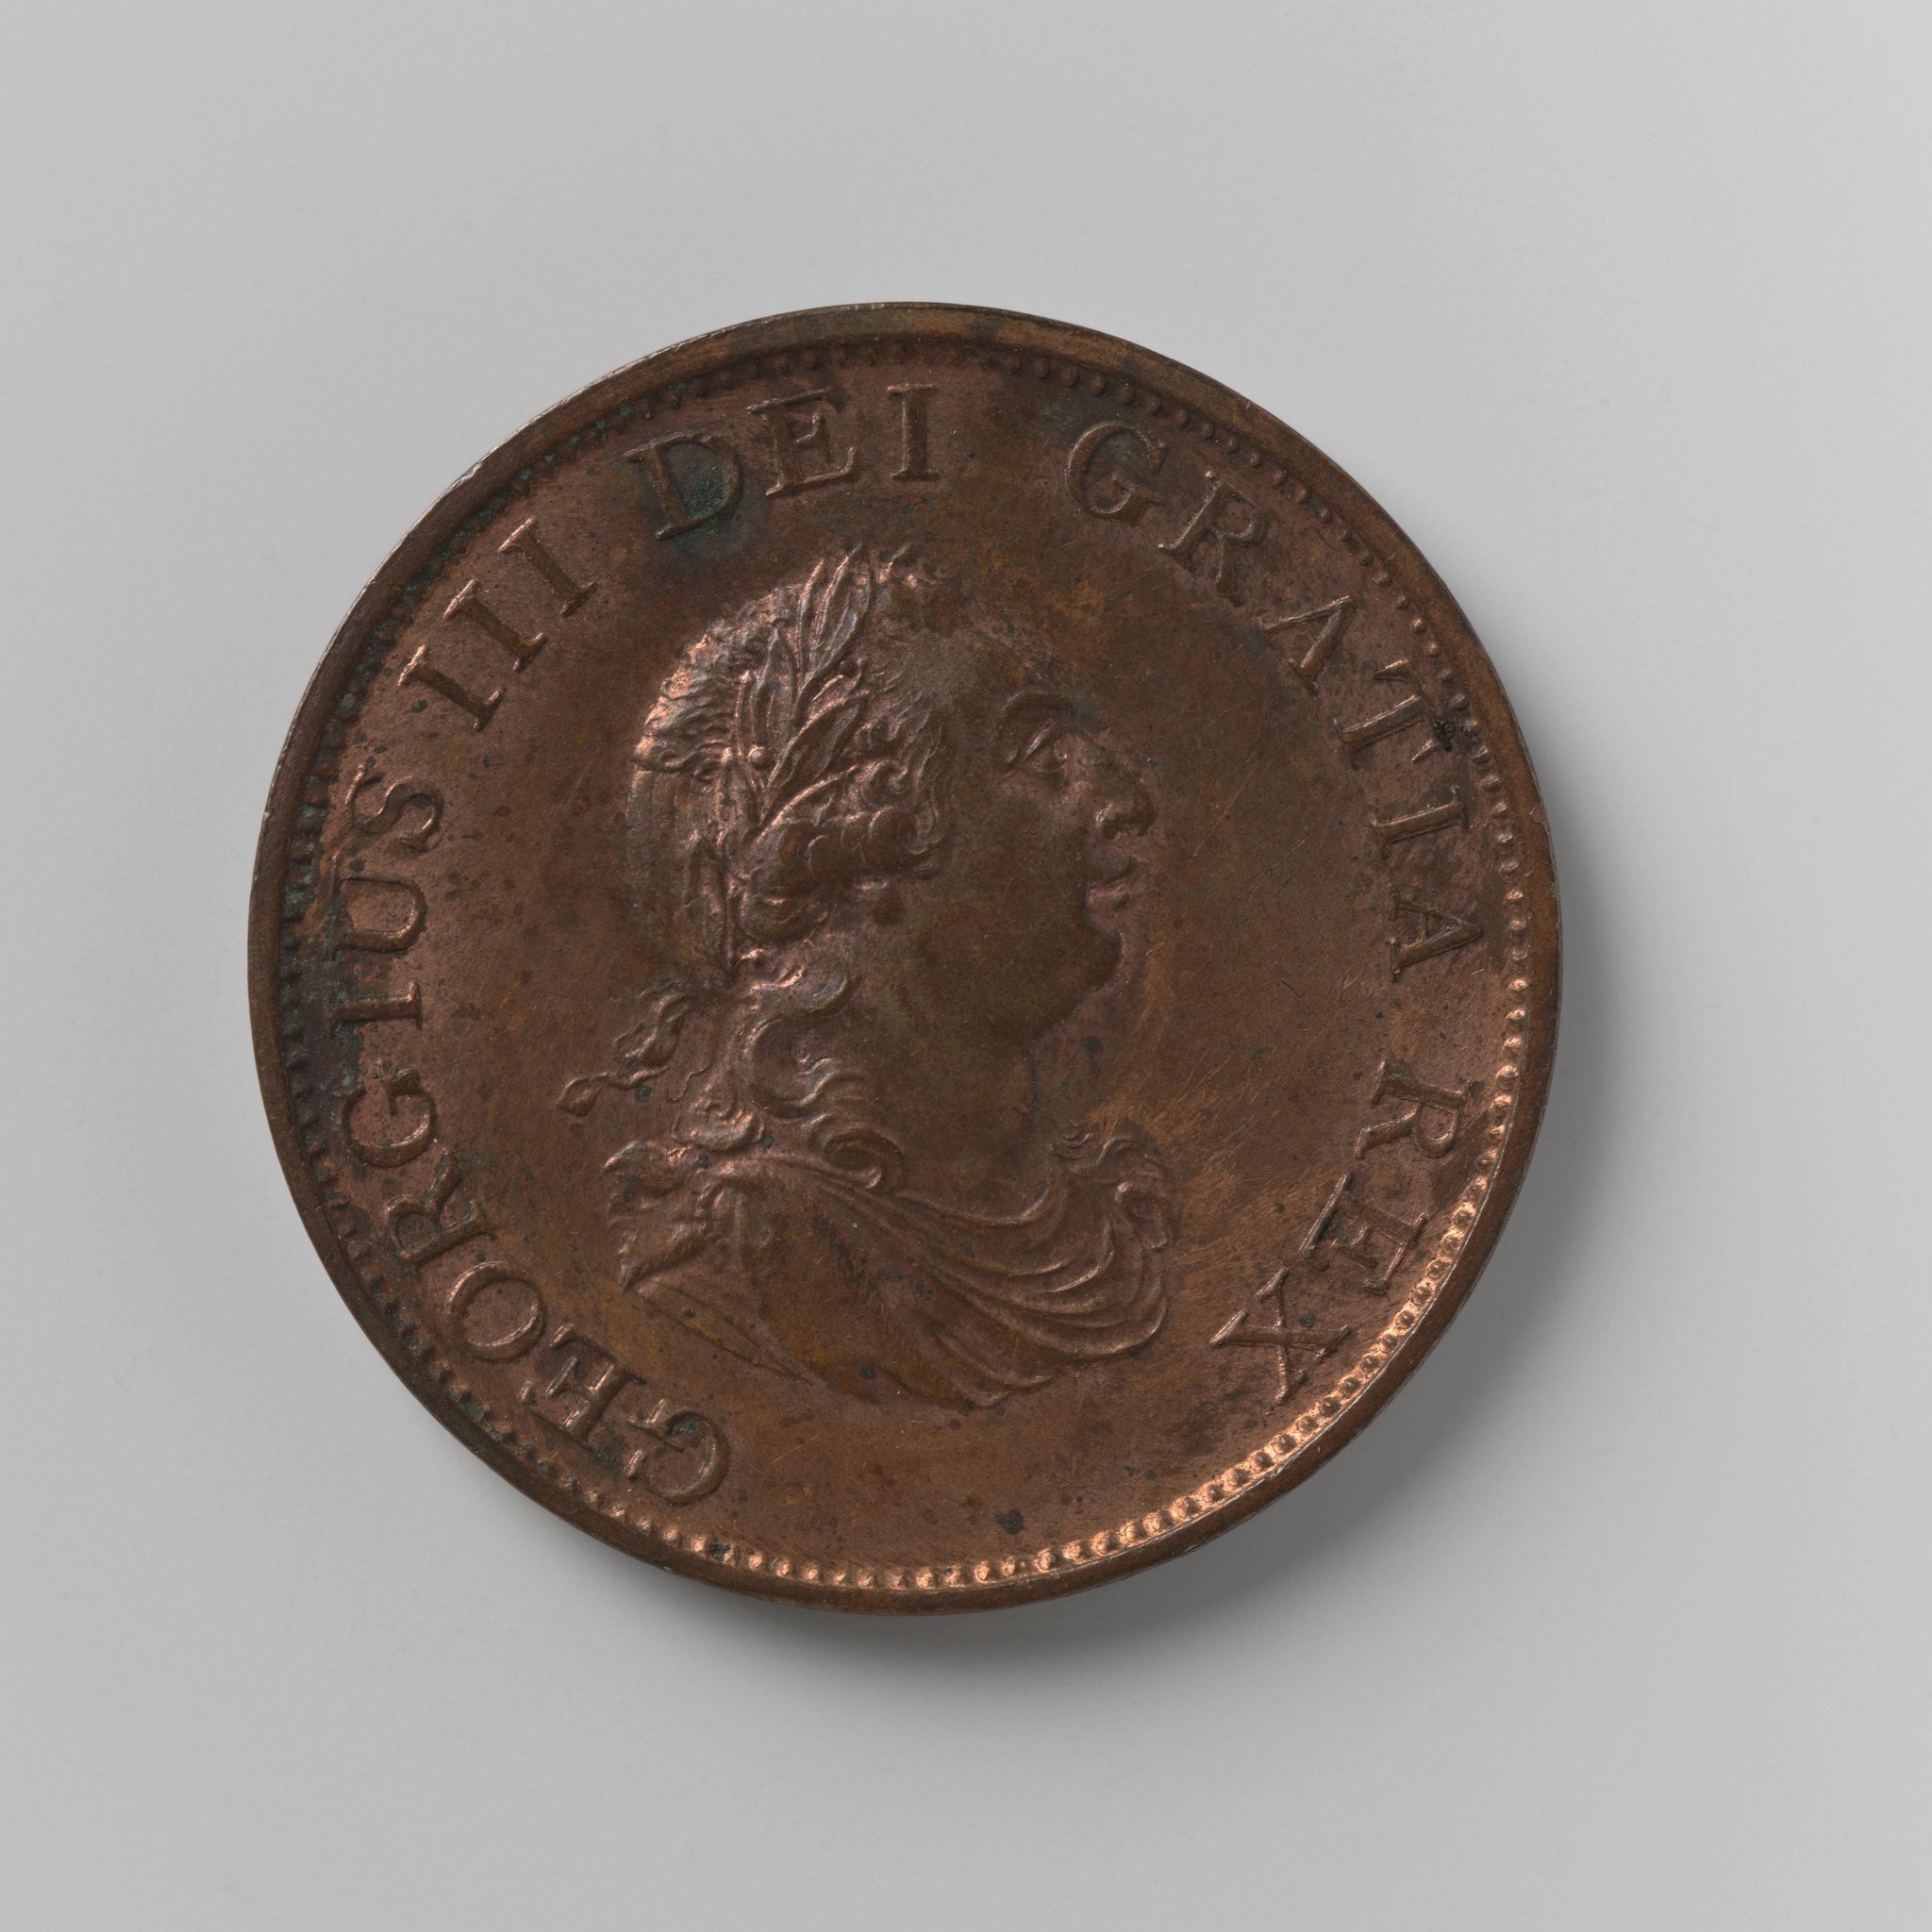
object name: coin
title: Engeland, George I, penny, 1799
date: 1799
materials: copper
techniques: striking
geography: birmingham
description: Koperen munt. Voorzijde: gelauwerd borstbeeld van de koning naar rechts. Keerzijde: op uit zee opstijgende rots, waartegen schild geplaatst, gezeten Brittannia met drietand en tak, naar links. Links van haar schip. Jaartal onderaan. Kartelrand.